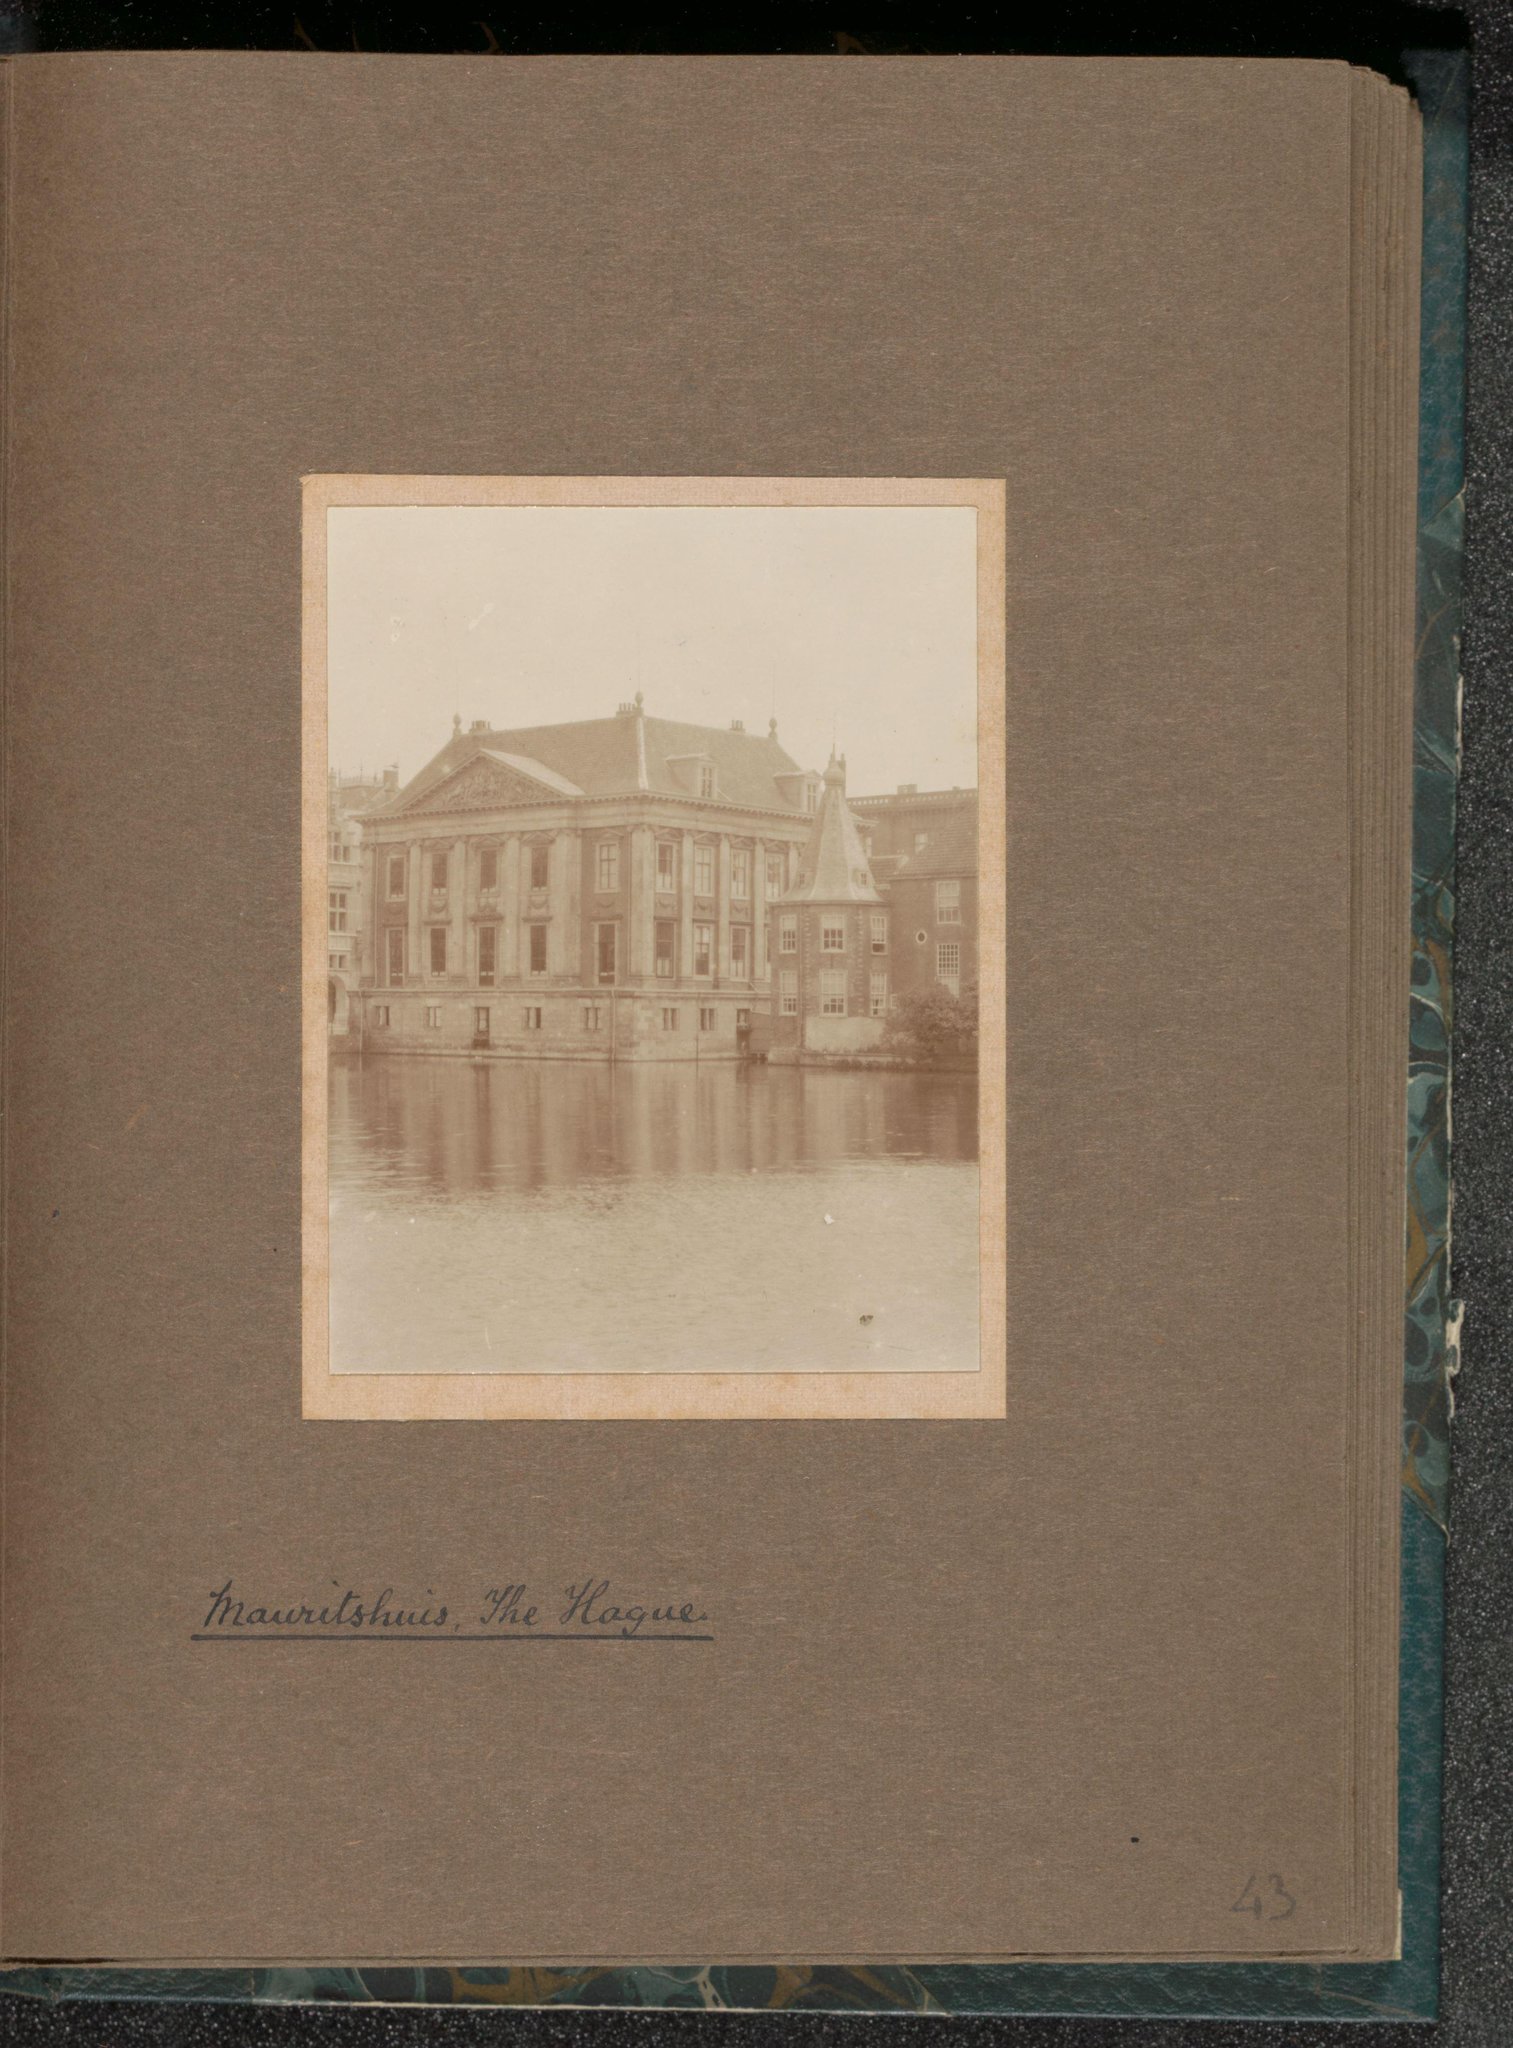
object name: photograph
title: Mauritshuis The Hague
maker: Anonymous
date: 1912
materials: photographic support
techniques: gelatin silver print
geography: the hague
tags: travelling; tourism, pond, the hague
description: Onderdeel van Fotoalbum van de excursie naar Nederland van de Britse amateurfotografenvereniging P.C.U.K.